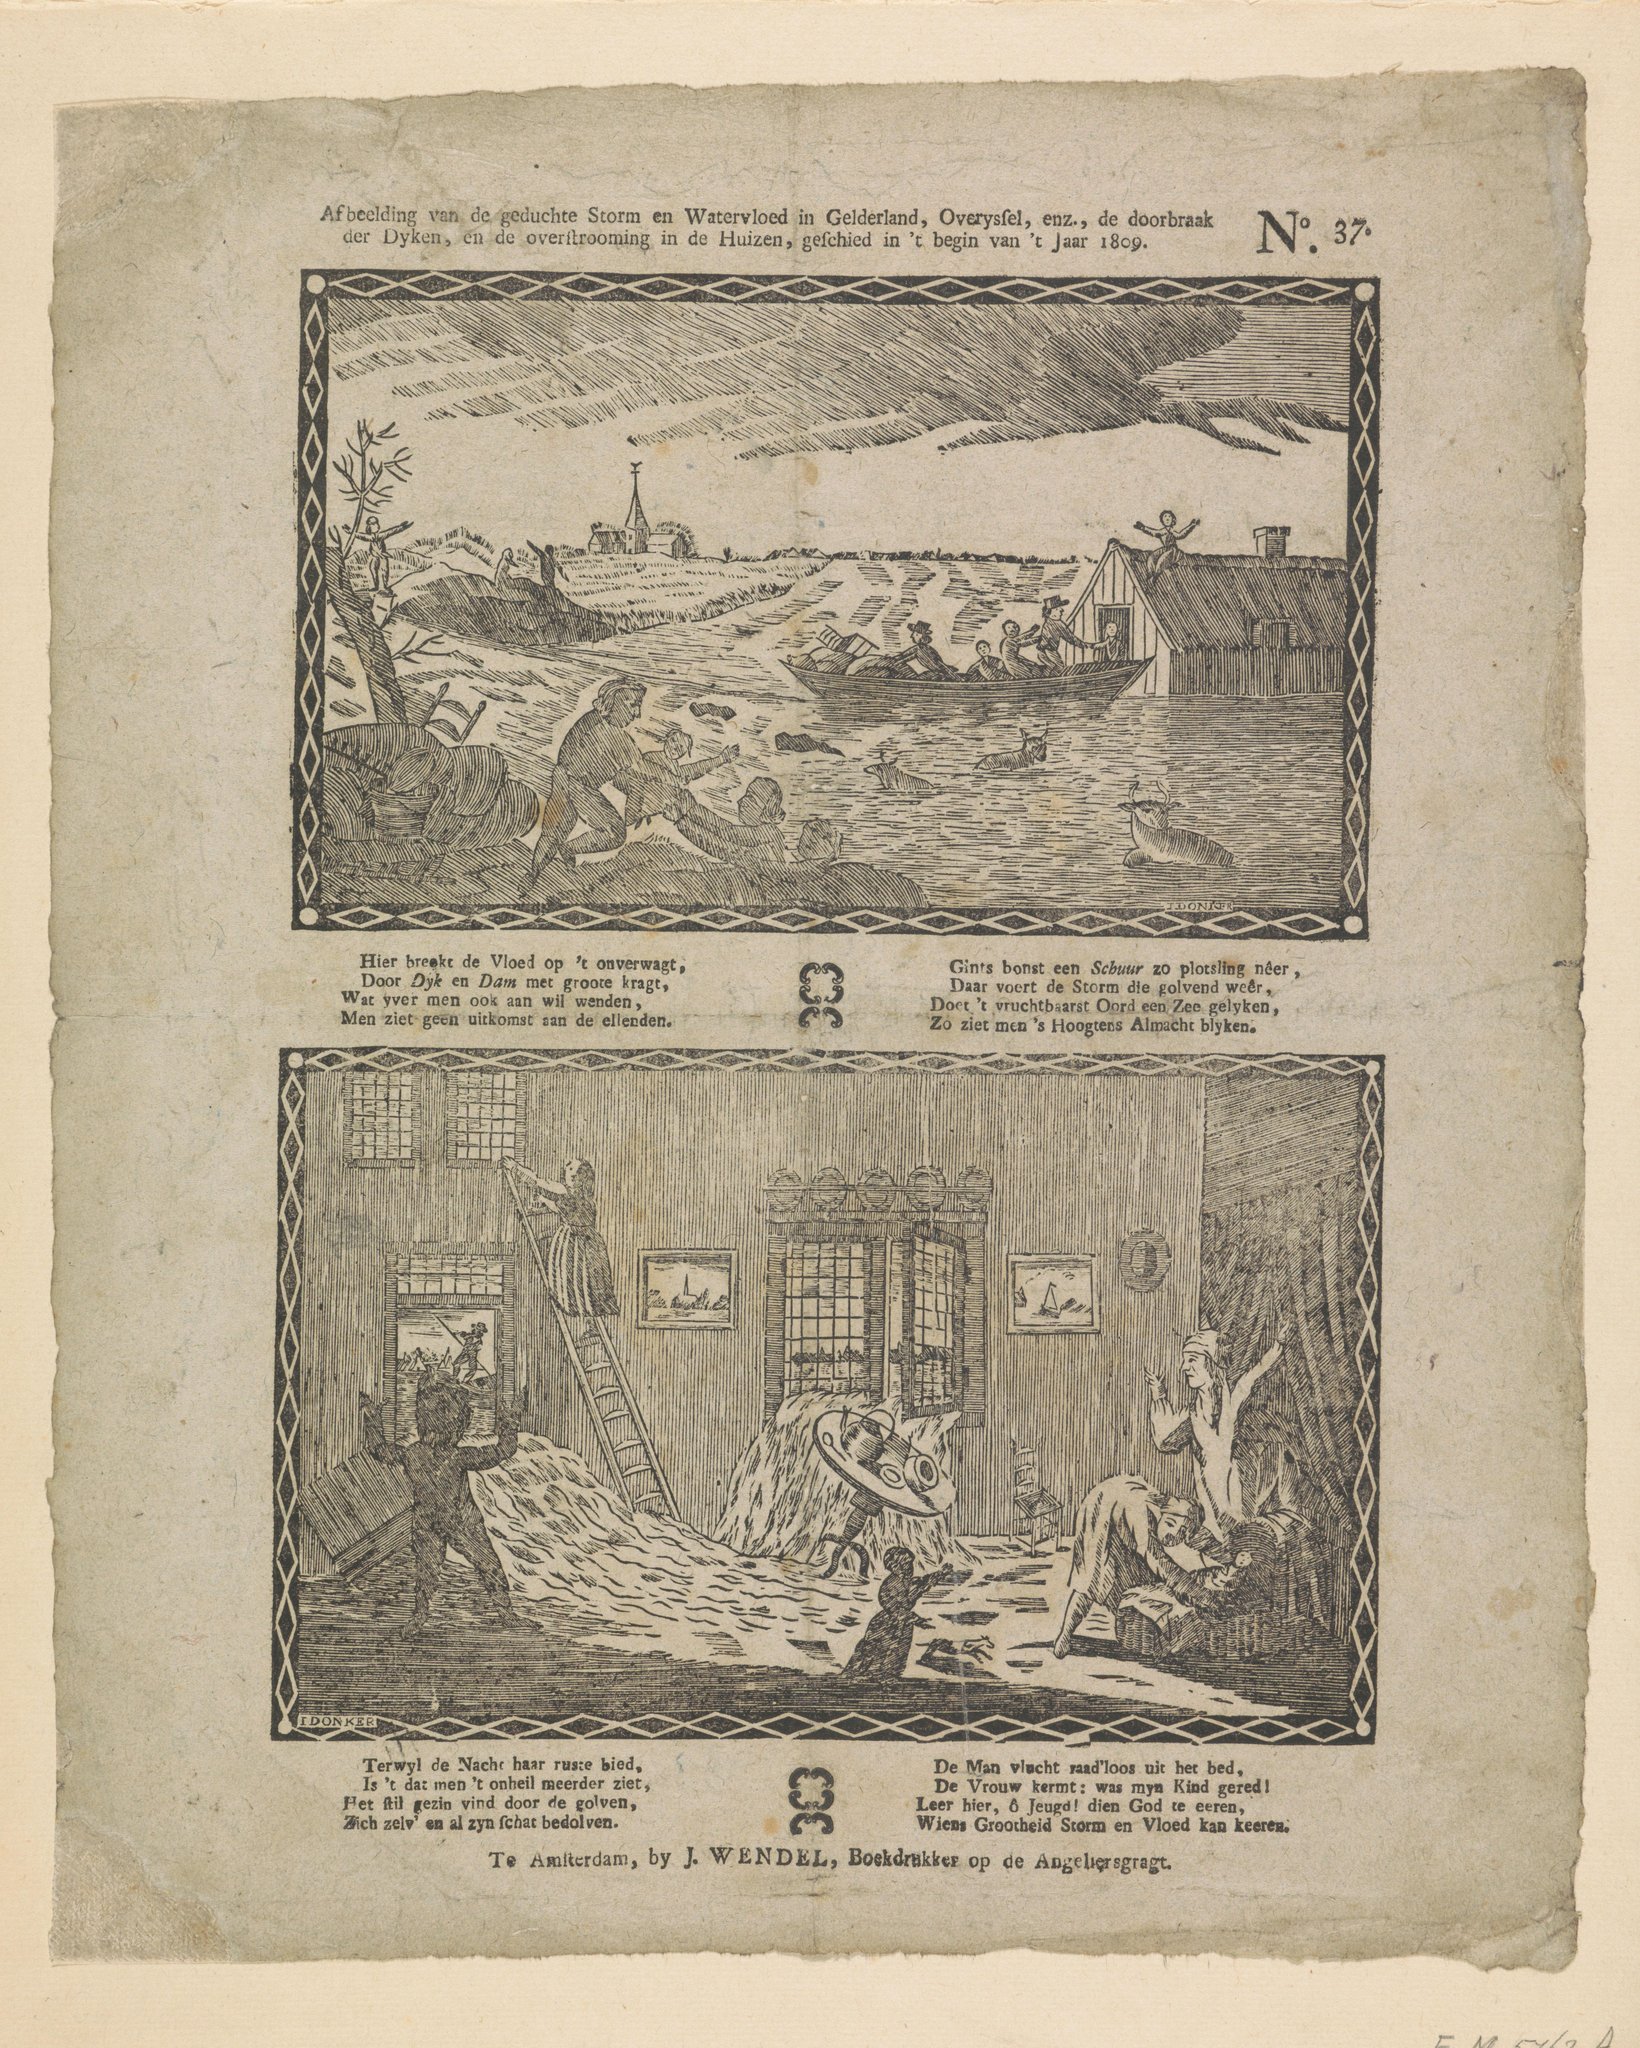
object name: popular print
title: Twee afbeeldingen van de watersnood in 1809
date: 1809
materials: paper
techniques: letterpress printing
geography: amsterdam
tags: dike-break, gelderland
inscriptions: collector's mark: Lugt 2228, collector's mark: Lugt 2760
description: Twee afbeeldingen van de watersnood in Gelderland en Overijssel in januari 1809. Boven: bewoners worden met een boot uit hun ondergelopen huis gered. Onder: Het water stroomt een huis binnen. Onder elke voorstellingen een achtregelig vers. Genummerd rechtsboven: No. 37.